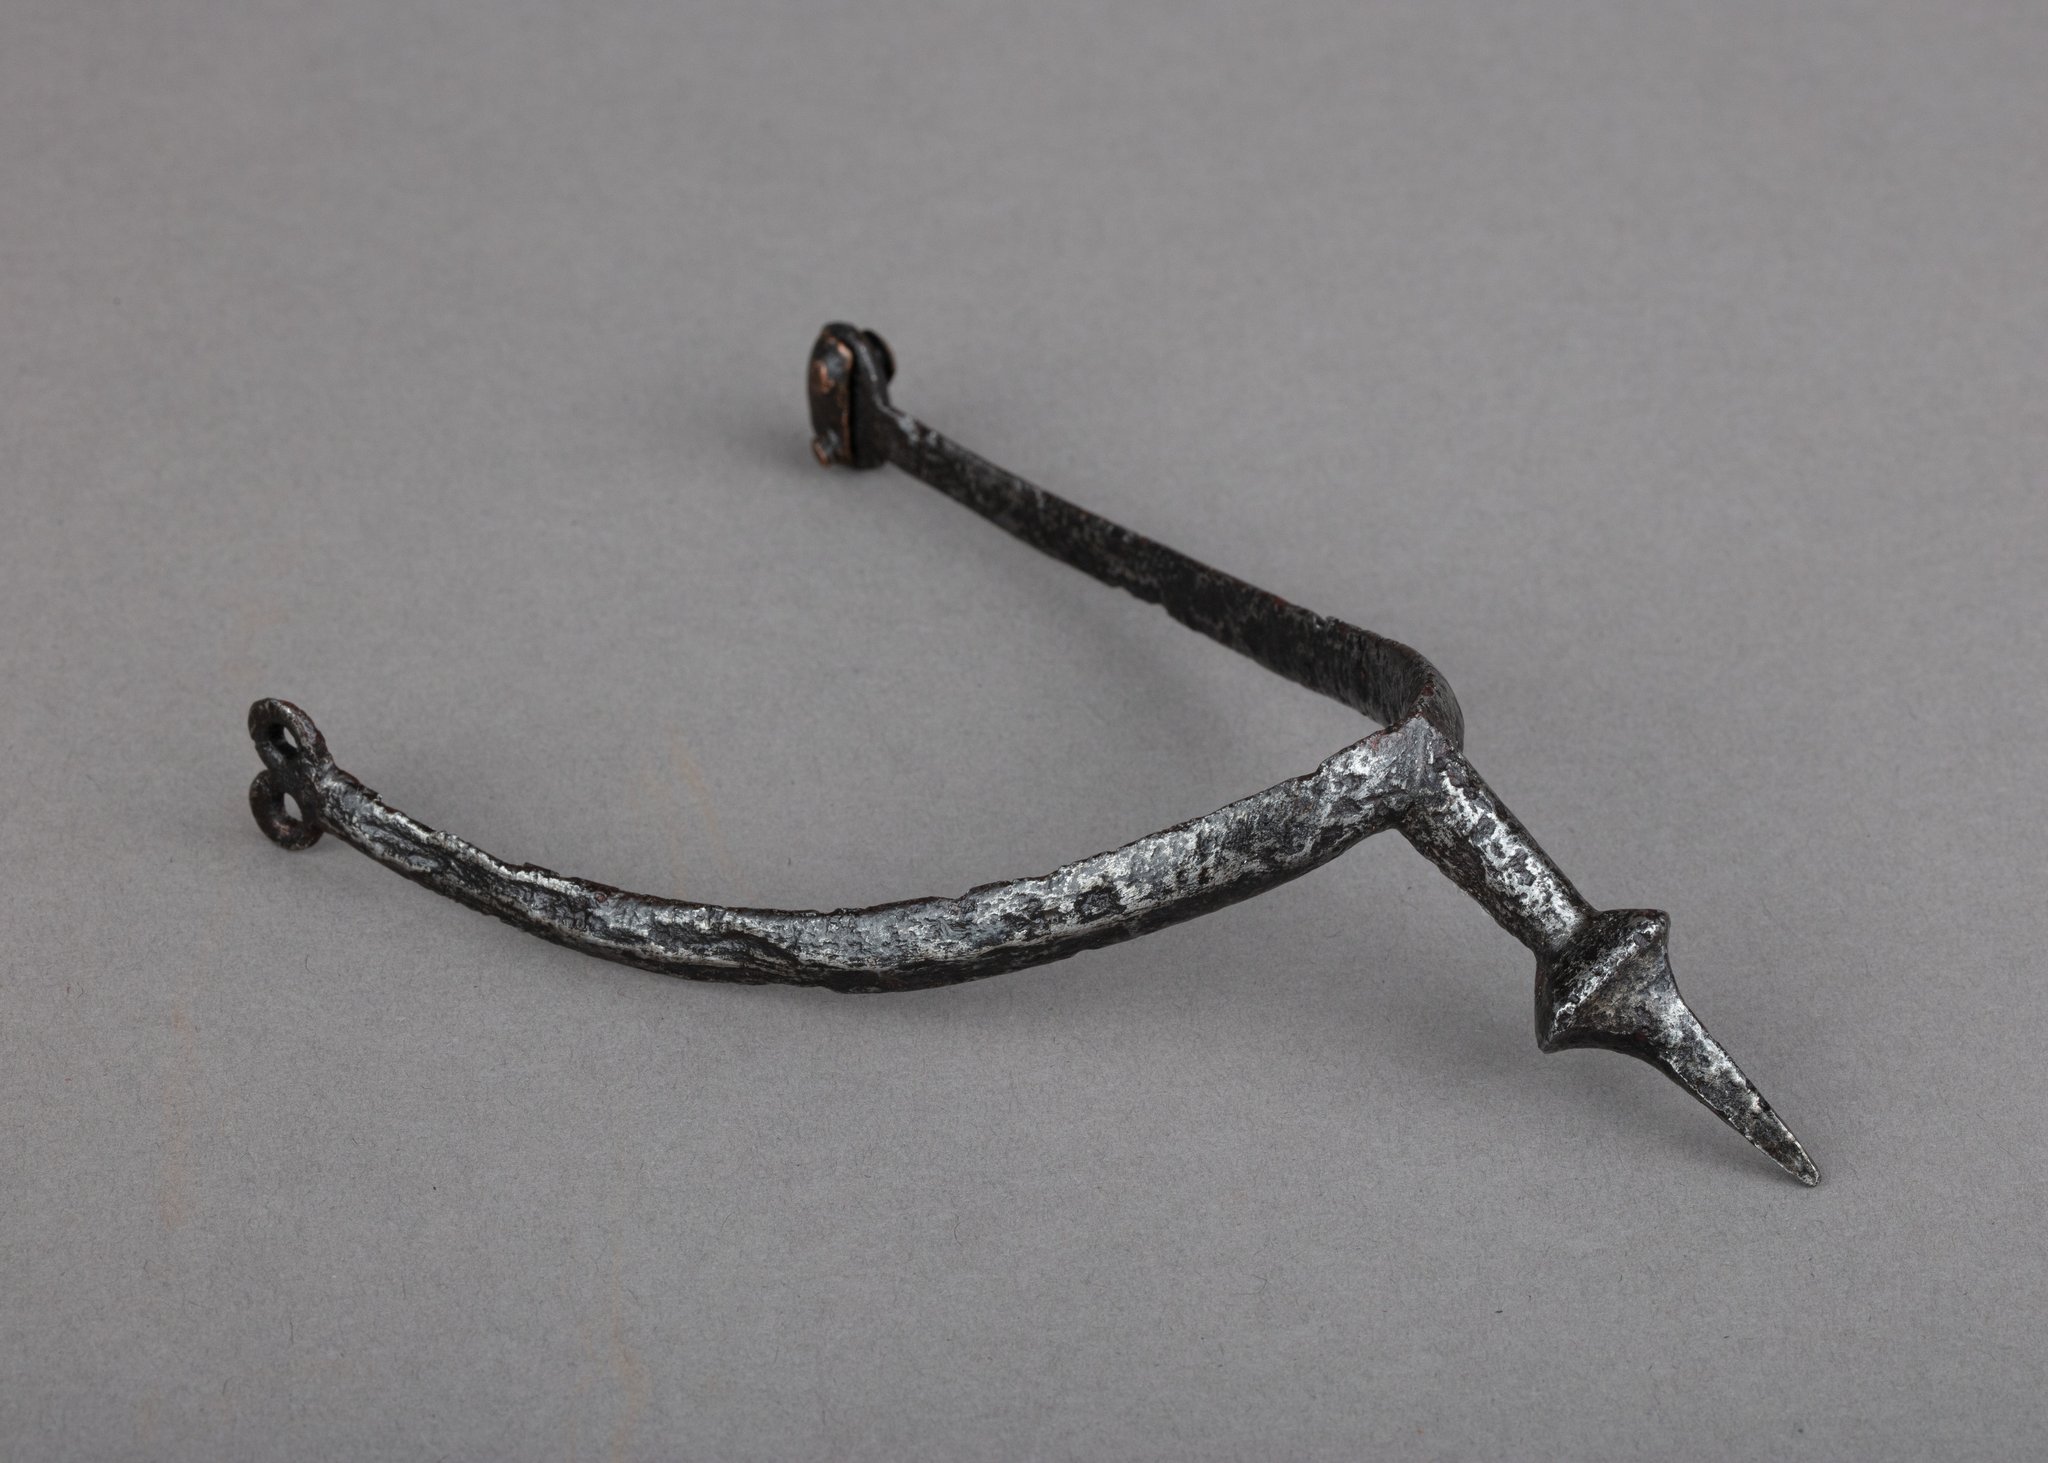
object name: spur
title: Prick Spur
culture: german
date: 1101-1200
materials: copper alloy, metal alloy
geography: germany